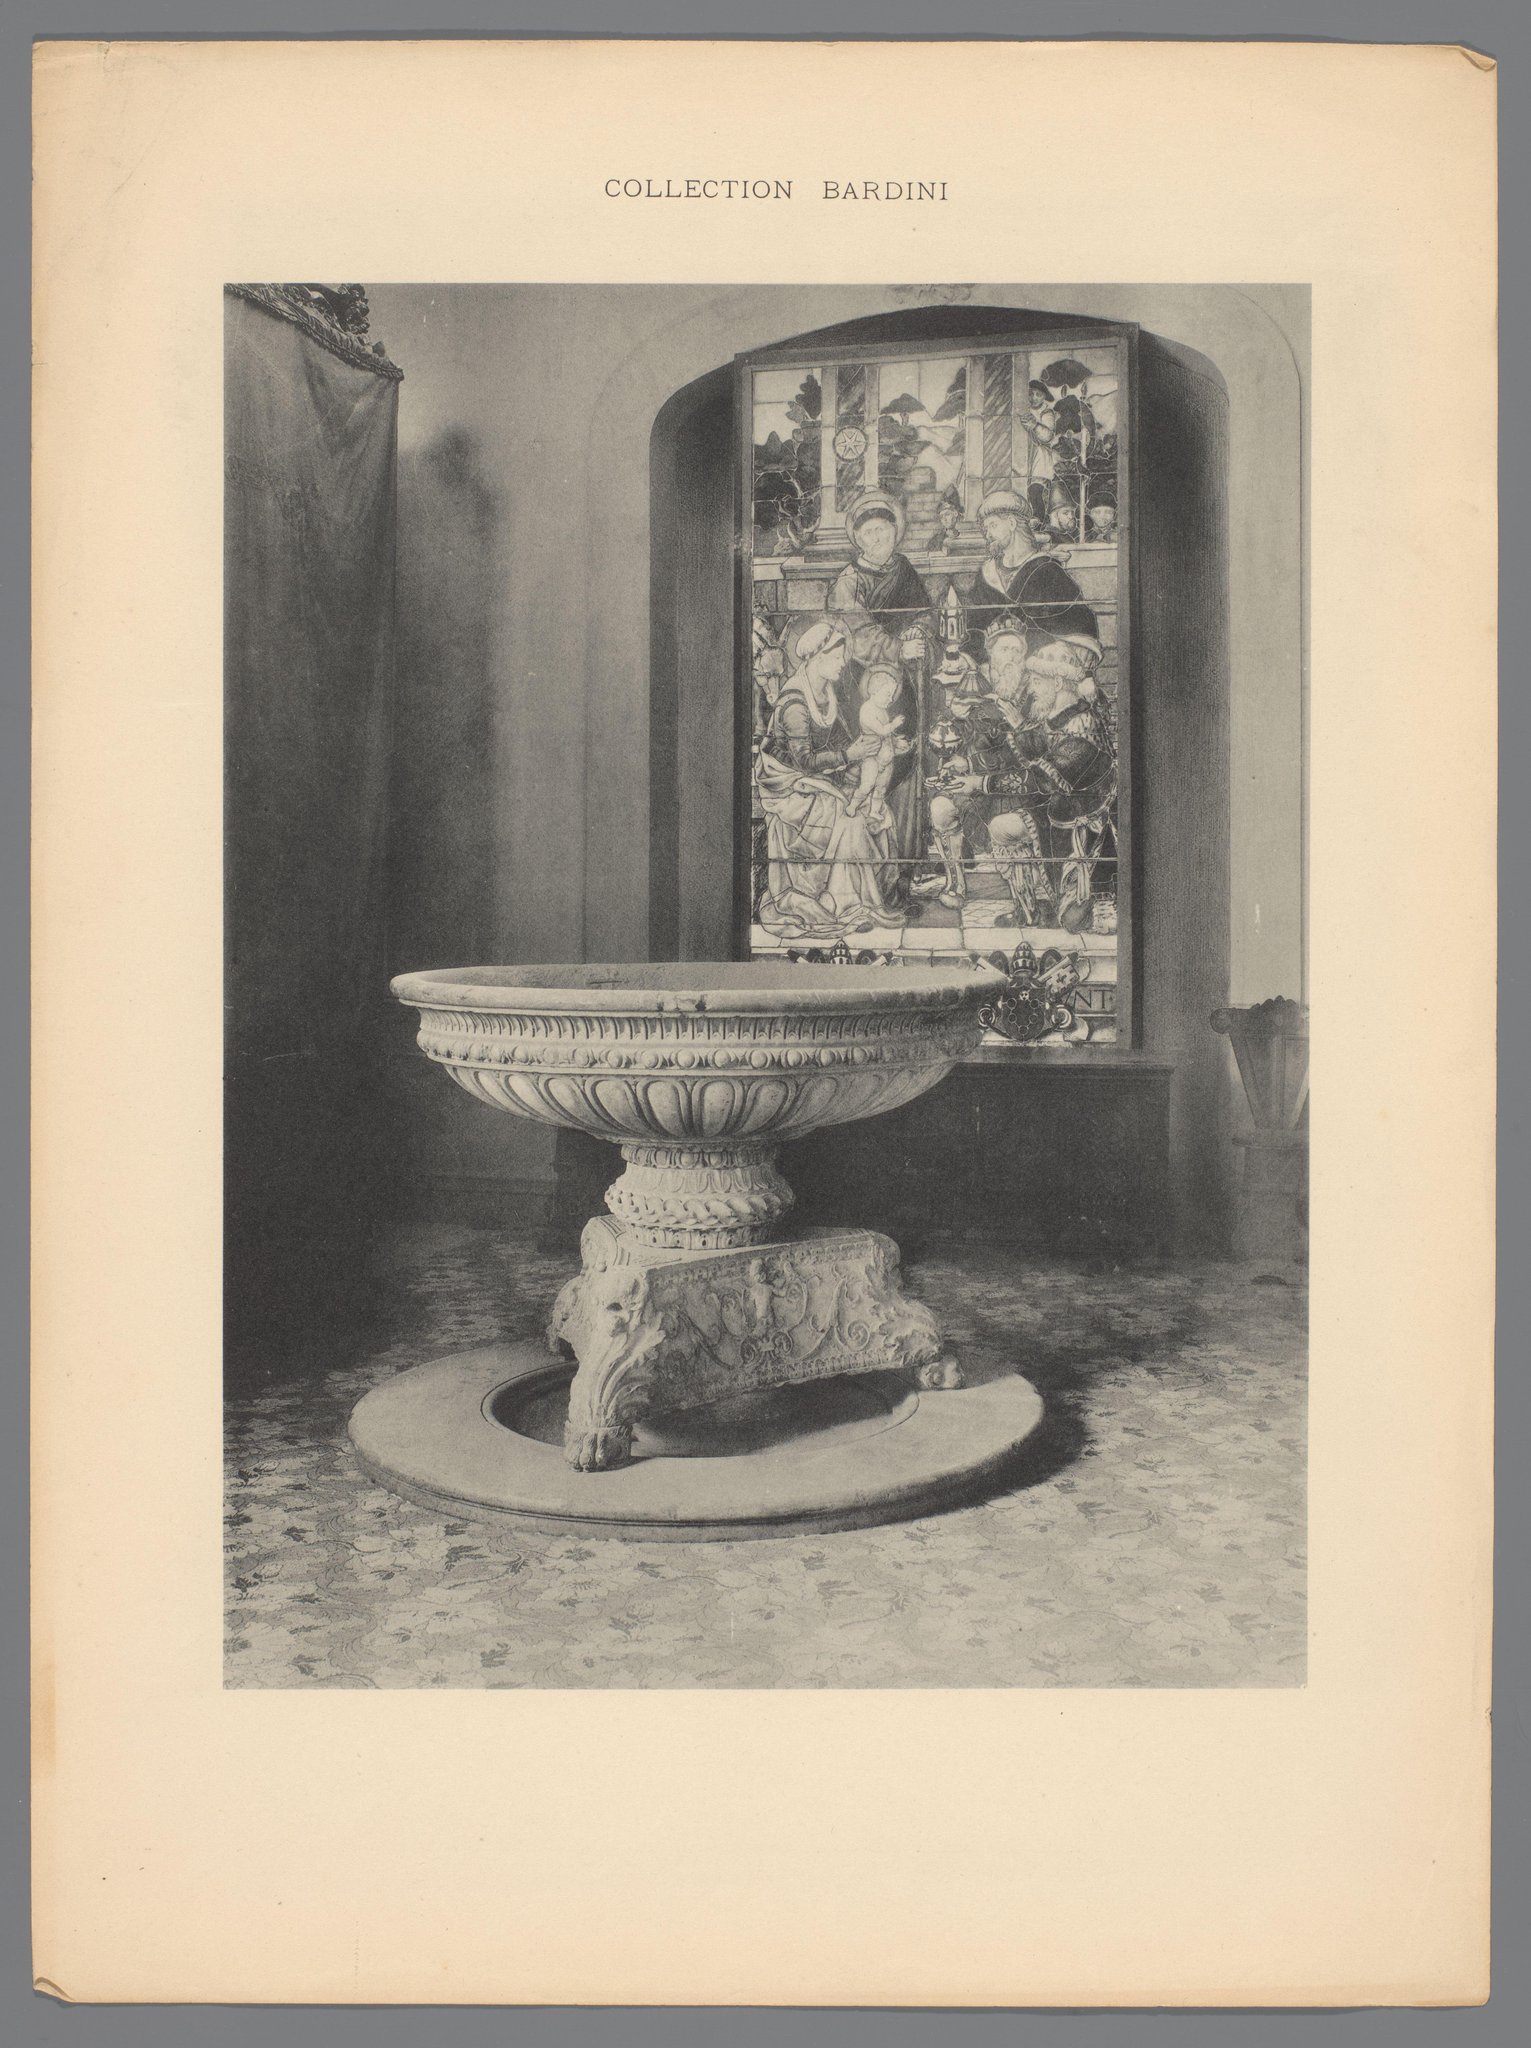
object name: photomechanical print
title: Collection Bardini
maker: Anonymous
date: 1875-1930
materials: paper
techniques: photograph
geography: florence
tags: sink, basin, permanent exhibition, museum